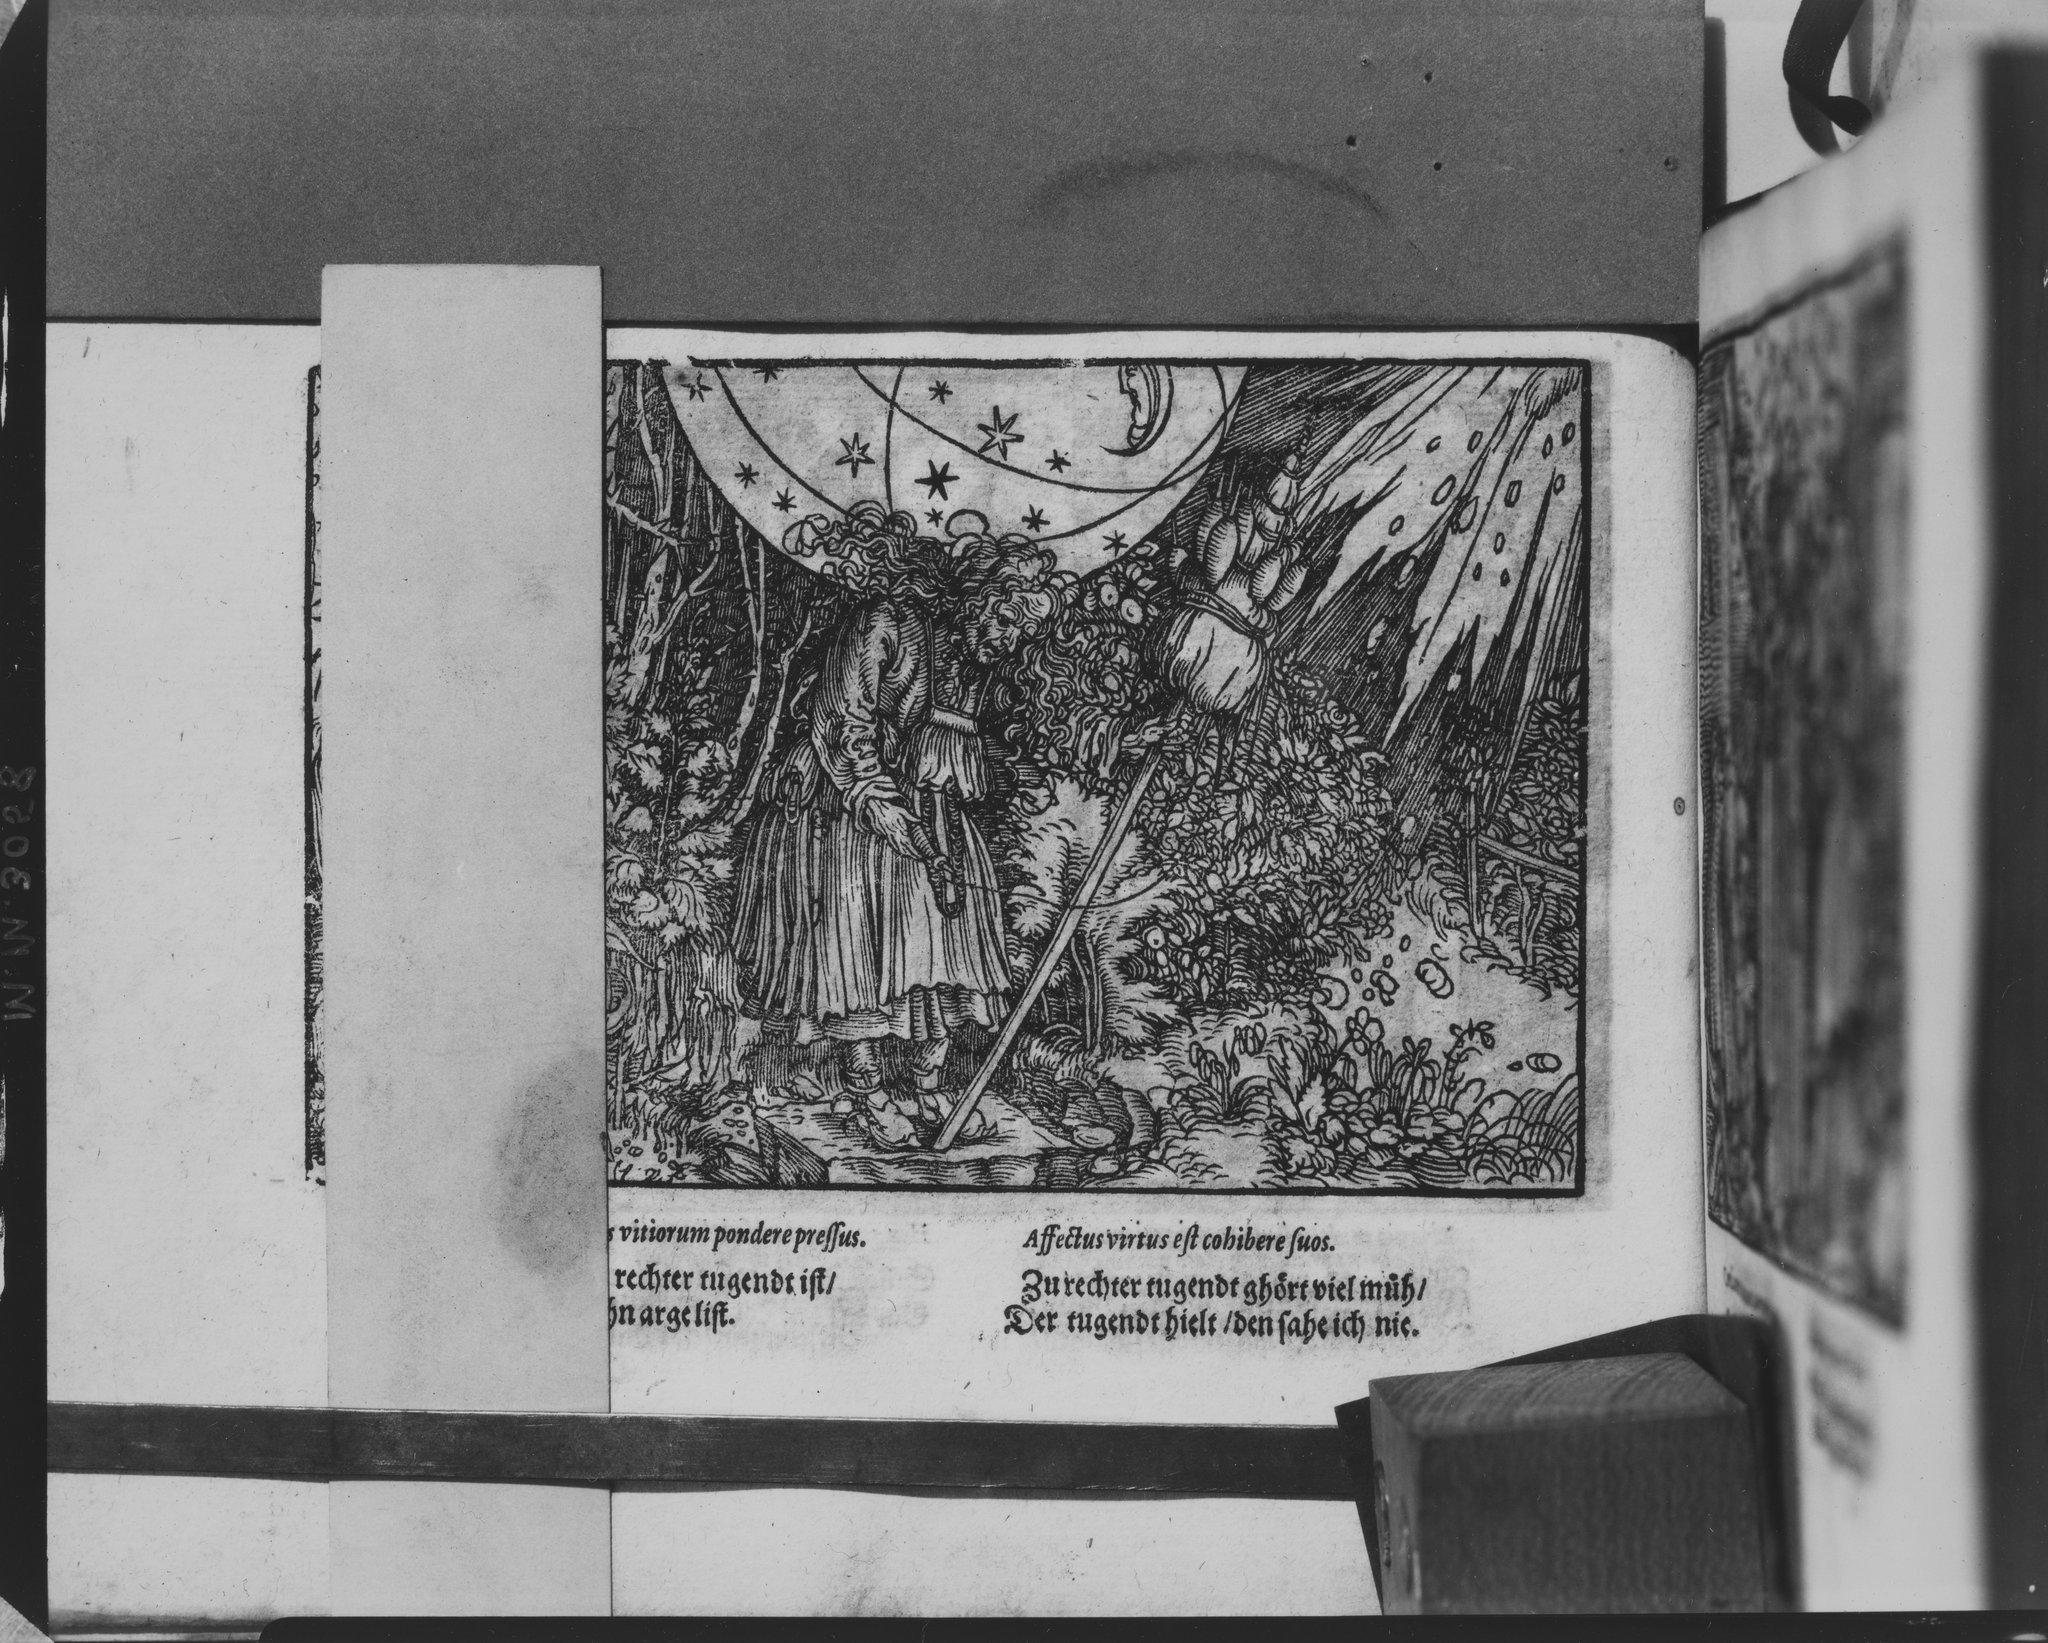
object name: book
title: Newe Künstliche Wohlgerissene unnd in Holtz geschnittene Figuren, dergleichen niemahlen gesehen worden. Von den fürtrefflichsten künstlichsten unnd Berühmbtesten Mahlern, Reissern unnd Formschneidern. Als nemblich Albrecht Dürer, Hanß Holbeyn, ....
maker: hans weiditz the younger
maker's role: artist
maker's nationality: german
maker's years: 1500-1536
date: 1620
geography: germany